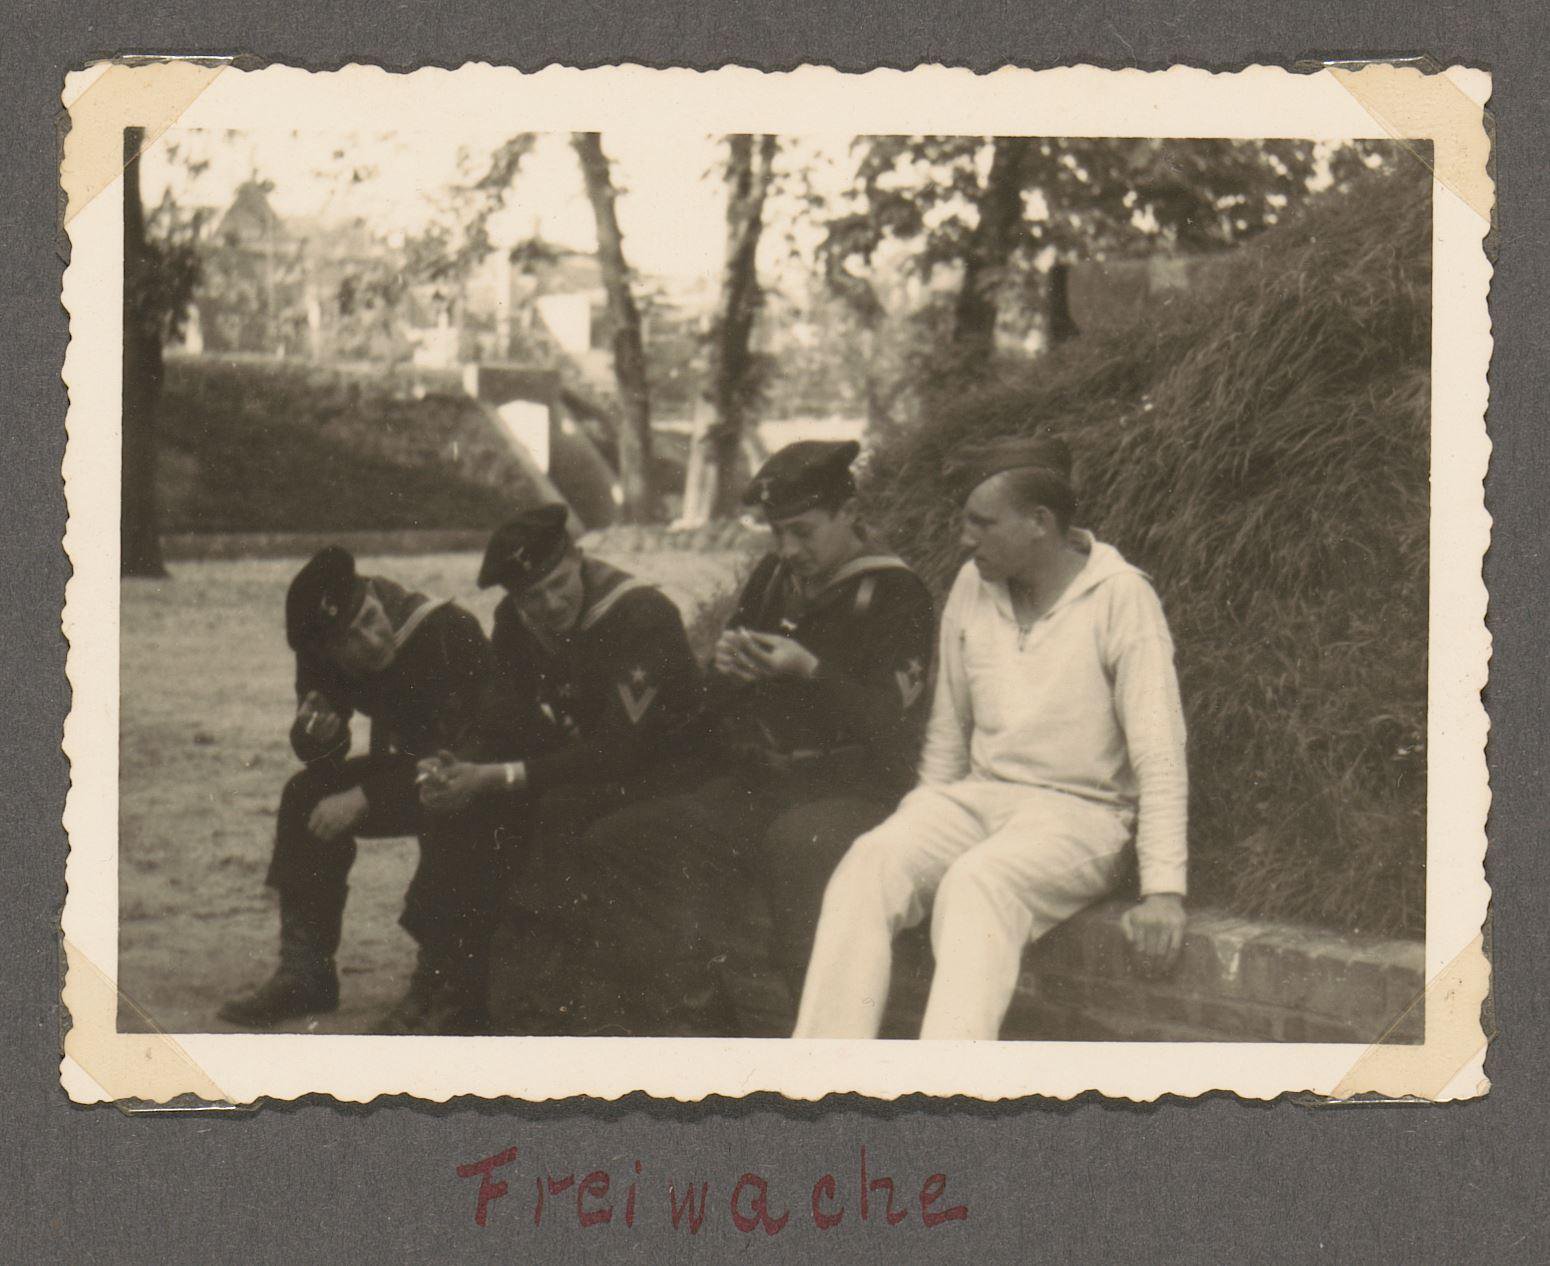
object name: photograph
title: Vier militairen tijdens een wisseling van de wacht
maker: Anonymous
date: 1941-1945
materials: paper, photographic support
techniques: gelatin silver print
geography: rotterdam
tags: the soldier; the soldier's life, occupation ~ war, rotterdam